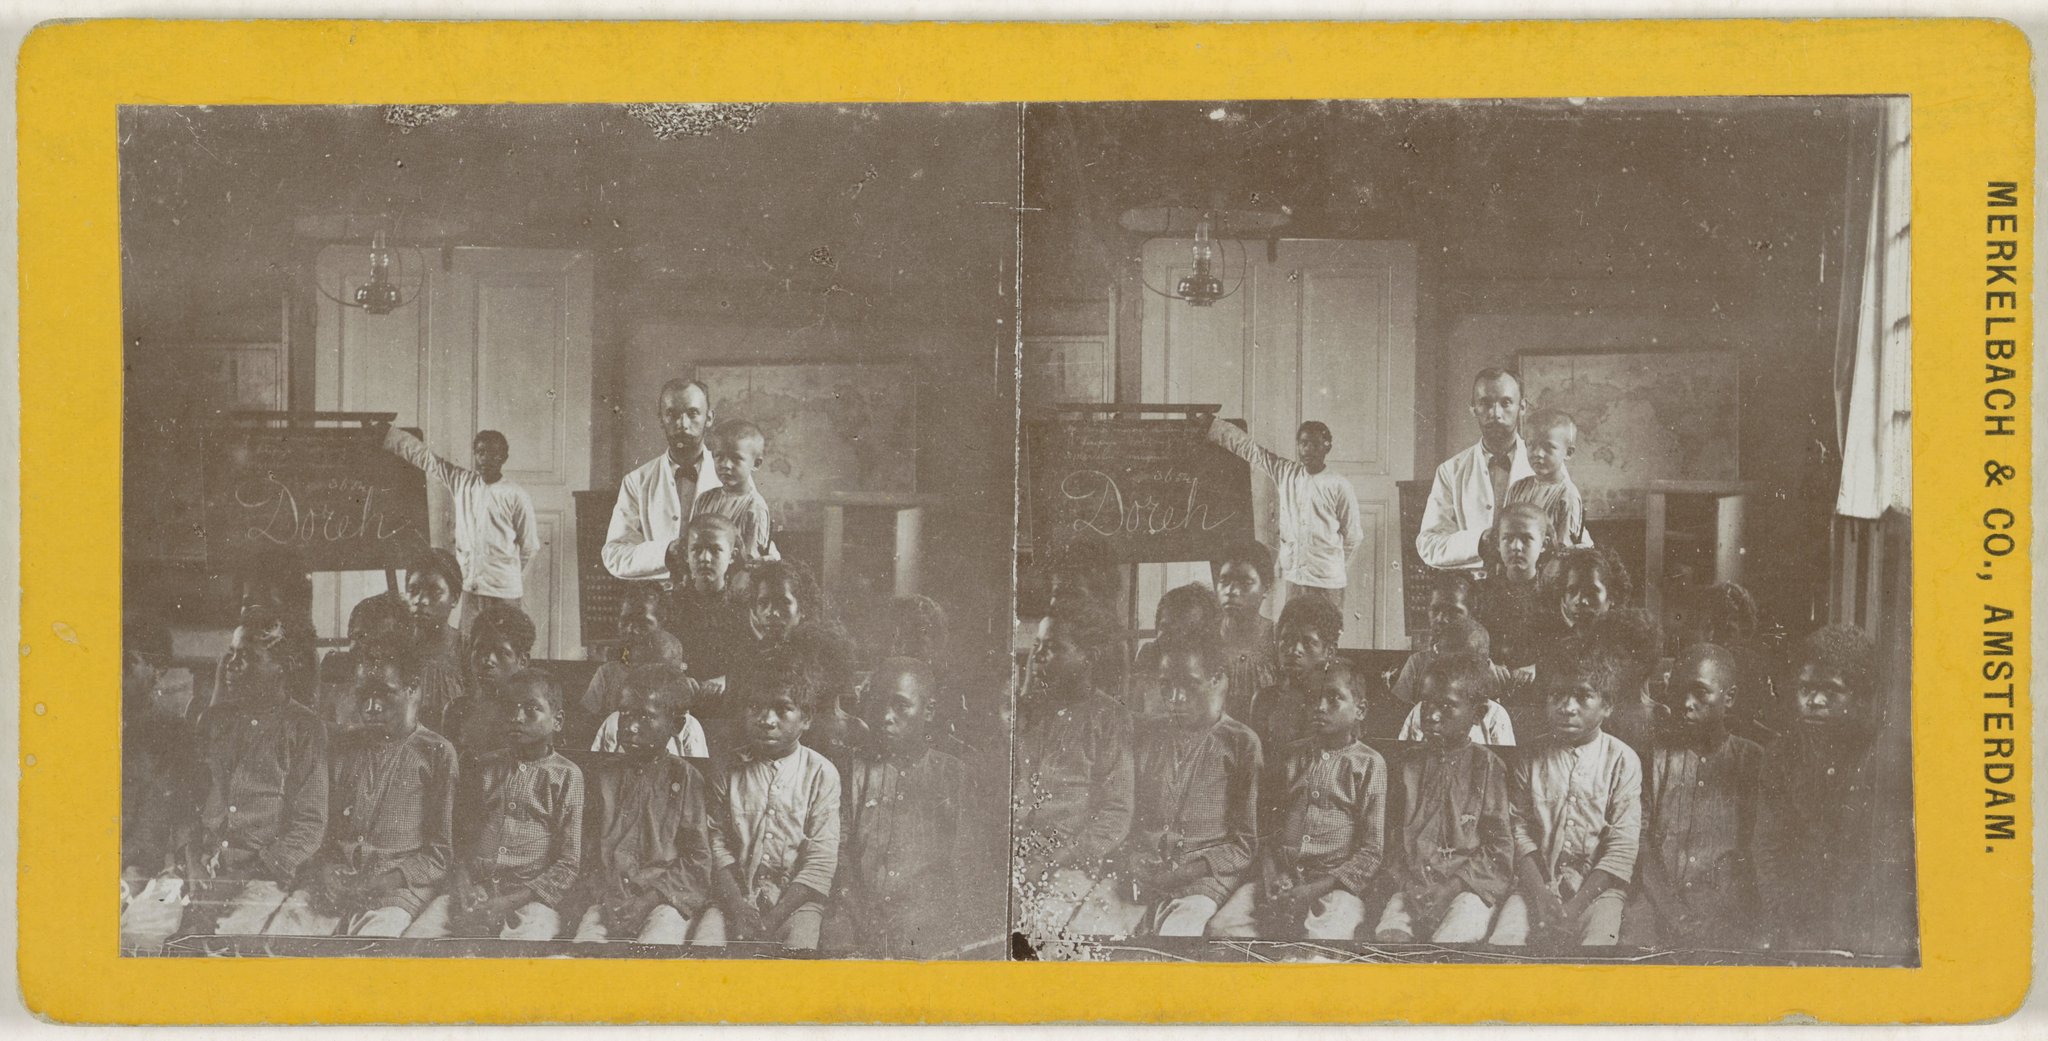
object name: stereograph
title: Schoolklas met onderwijzer in Manokwari, Indonesië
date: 1900-1902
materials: paper, cardboard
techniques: gelatin silver print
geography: amsterdam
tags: elementary school; class, form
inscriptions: inscription: ‘(Zie pl. 16.) Op den achtergrond bij het bord staat de goeroe,/ (Inlandsche onderwijzer,) die door de zendelingen aangesteld is in de ook/ door hen gestichte school. (...)’, number: ‘17.’